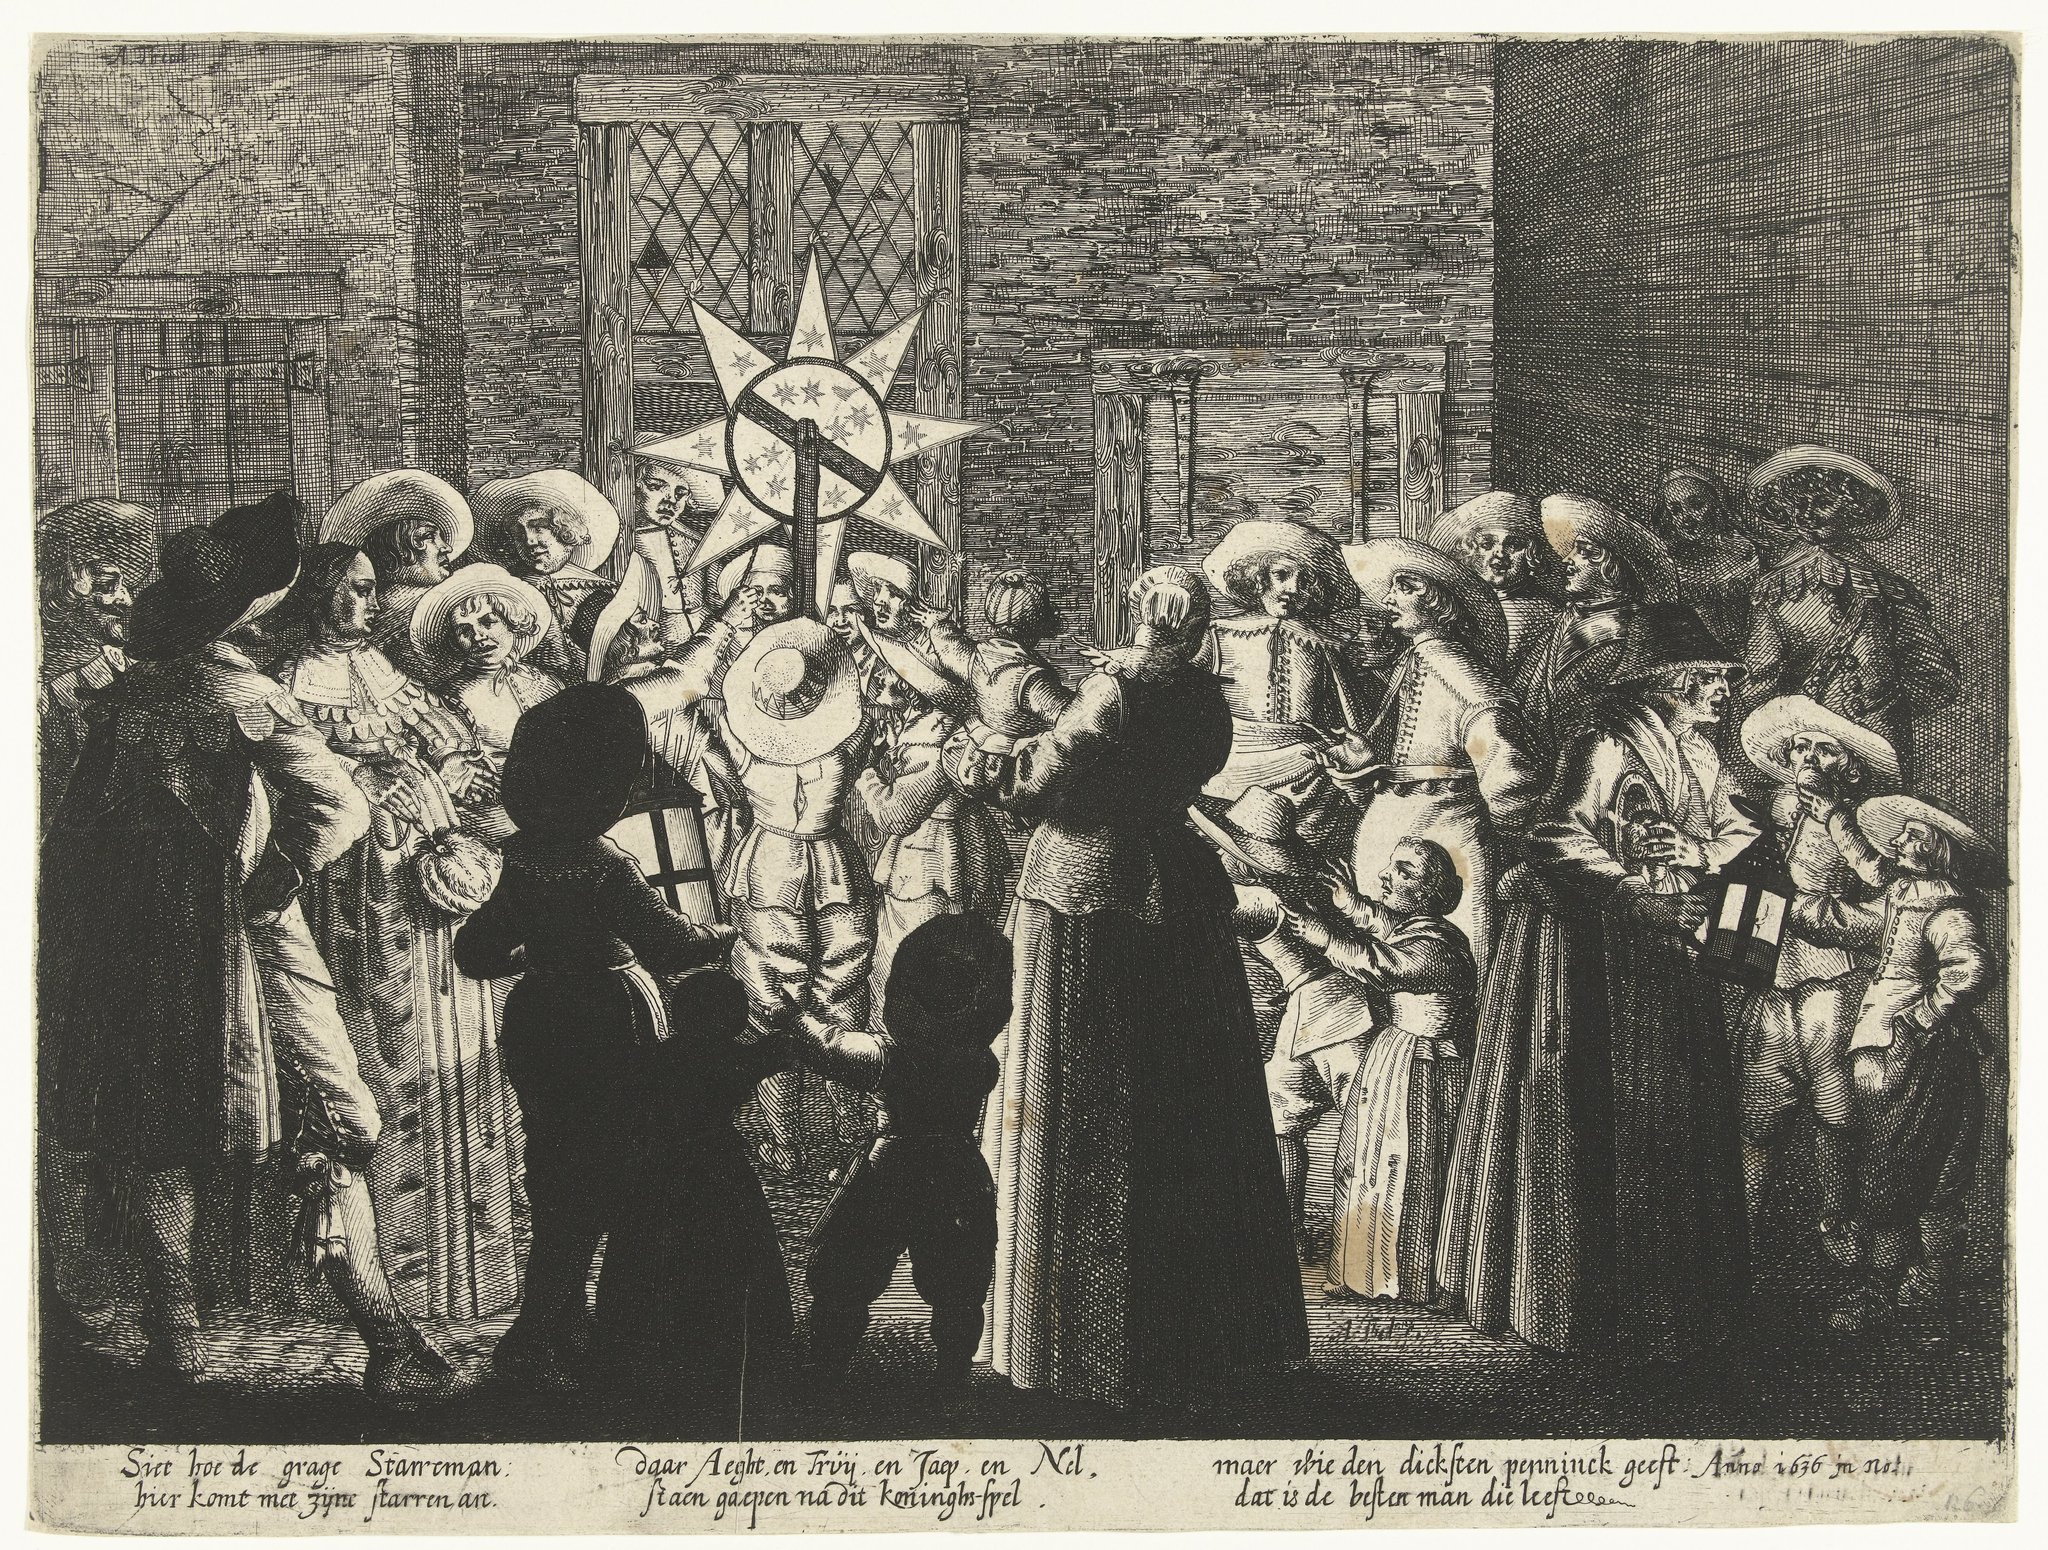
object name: print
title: De ster van de koningen, 1636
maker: a theodore (braham?)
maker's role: print maker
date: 1636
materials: paper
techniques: engraving, etching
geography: low countries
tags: twelfth night, usually falling on the eve of january 6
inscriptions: collector's mark: Lugt 240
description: Zingend gezelschap verzameld rond een groep kinderen op straat met de ster op Driekoningenavond, de avond vóór 6 januari. In het onderschrift een vers in 3 keer 2 regels.